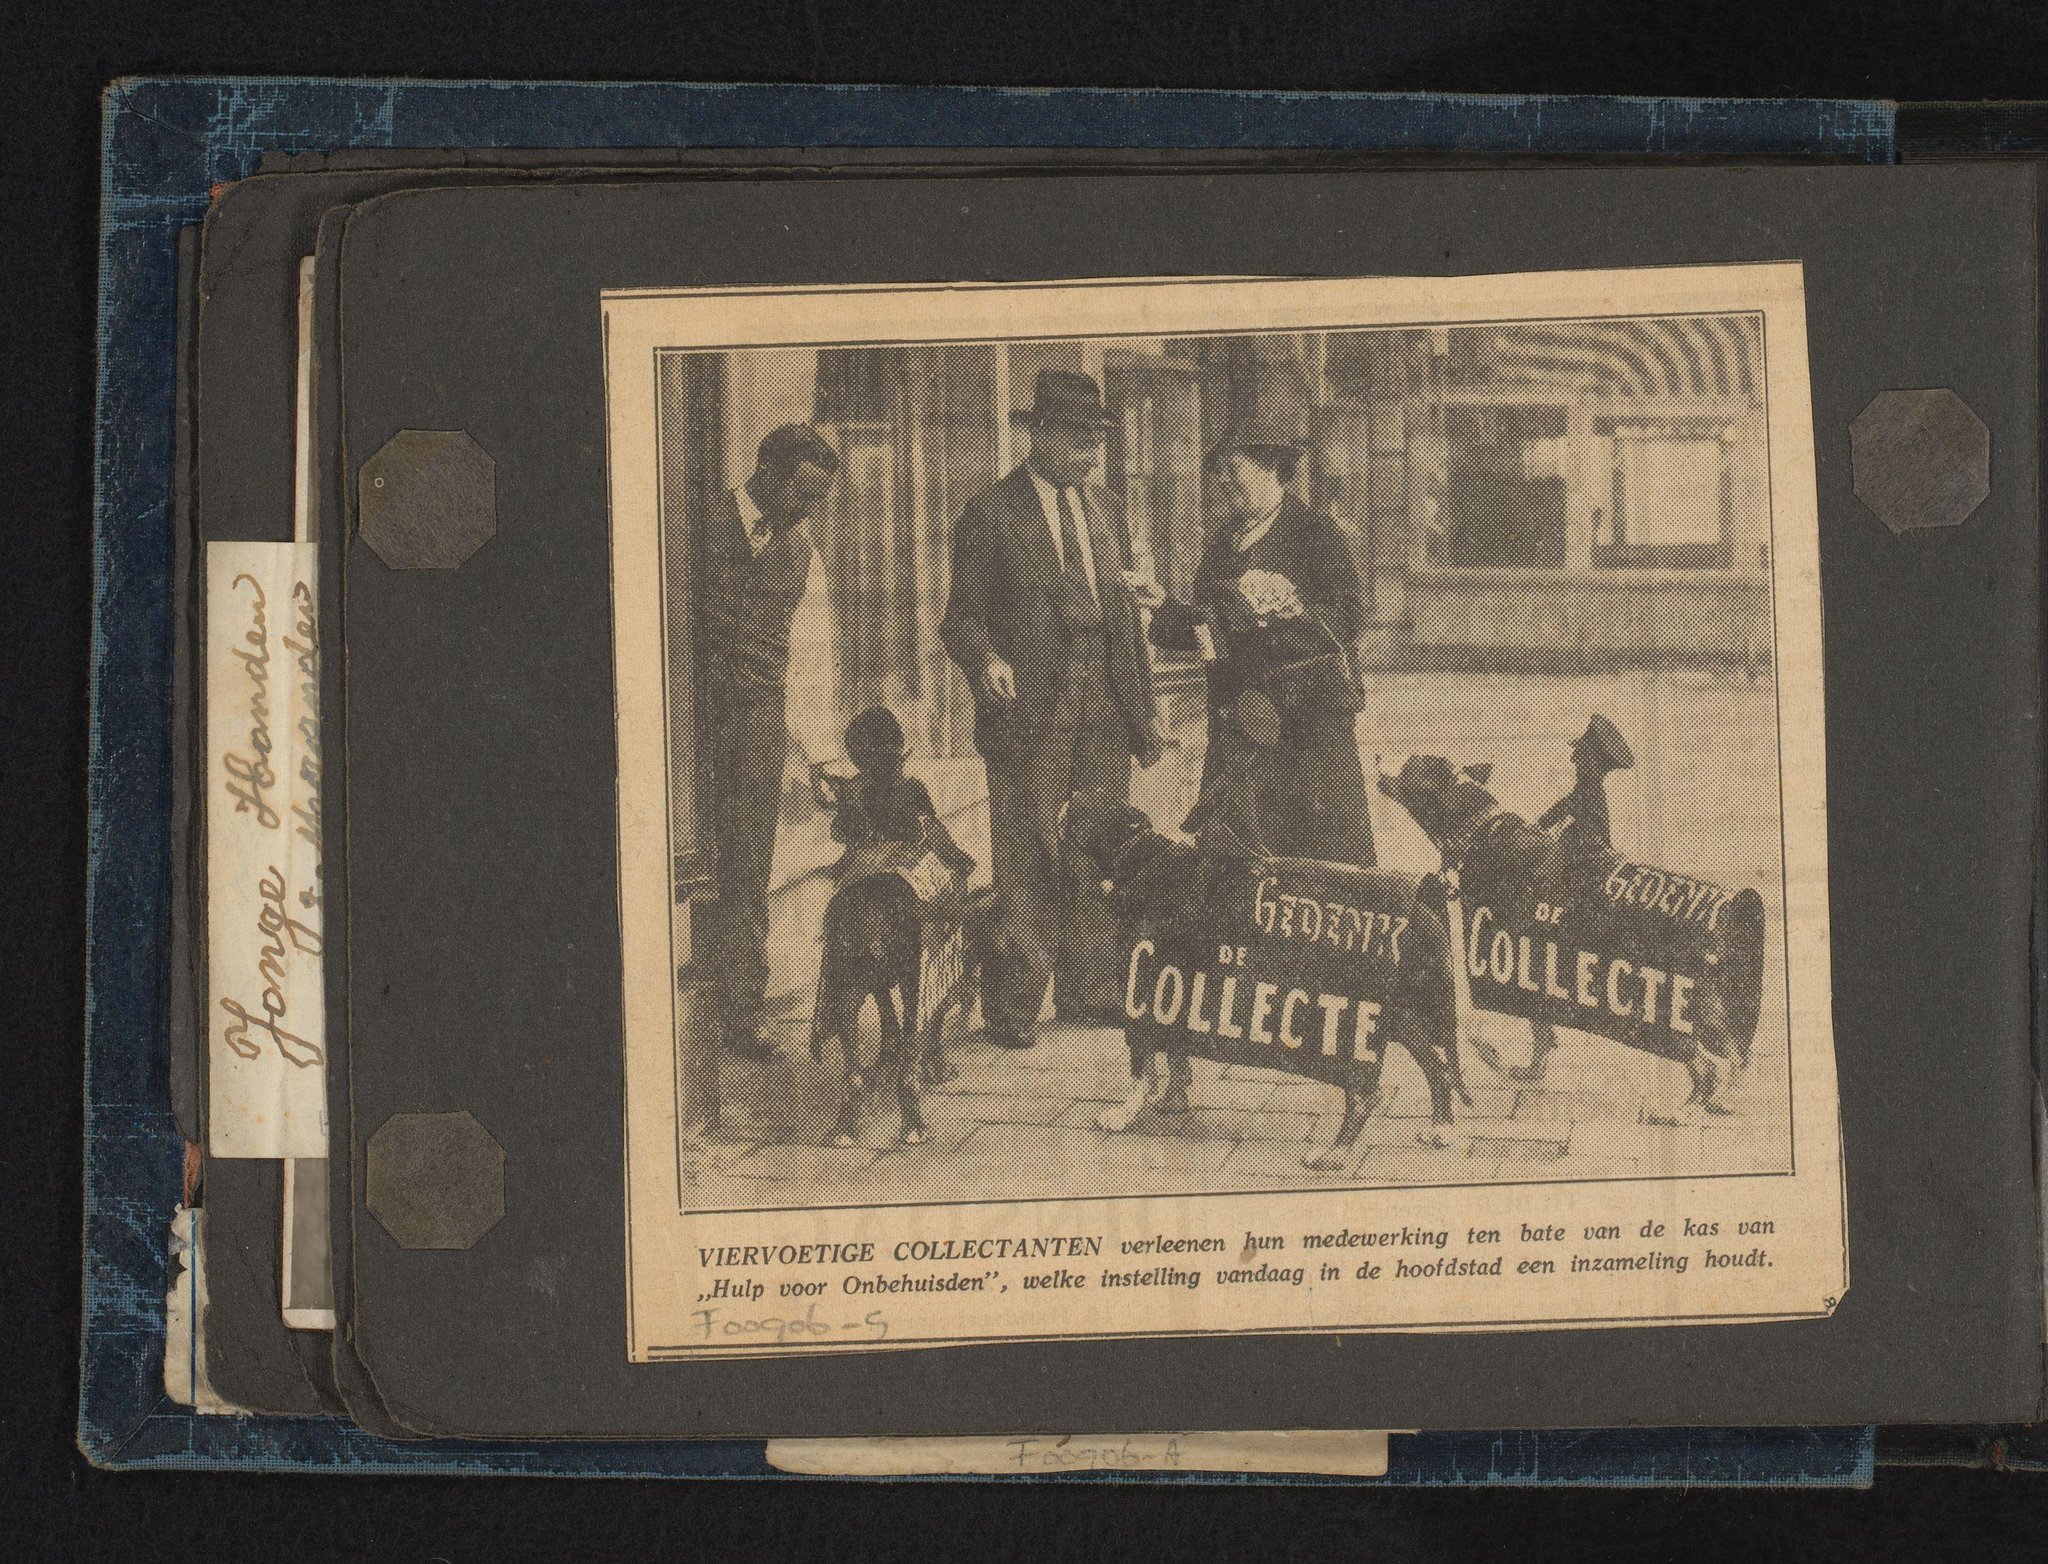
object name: newspaper clipping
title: Honden met reclameteksten bij een collecte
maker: Anonymous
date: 1930-1940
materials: paper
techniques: autotype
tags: advertising, adult man, historical persons, dog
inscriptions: inscription: ‘Viervoetige Collectanten verleenen hun medewerking ten bate van de kas van/ "Hulp voor Onbehuisden", welke instelling vandaag in de hoofdstad een inzameling houdt.’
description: Deze prent maakt deel uit van een album.